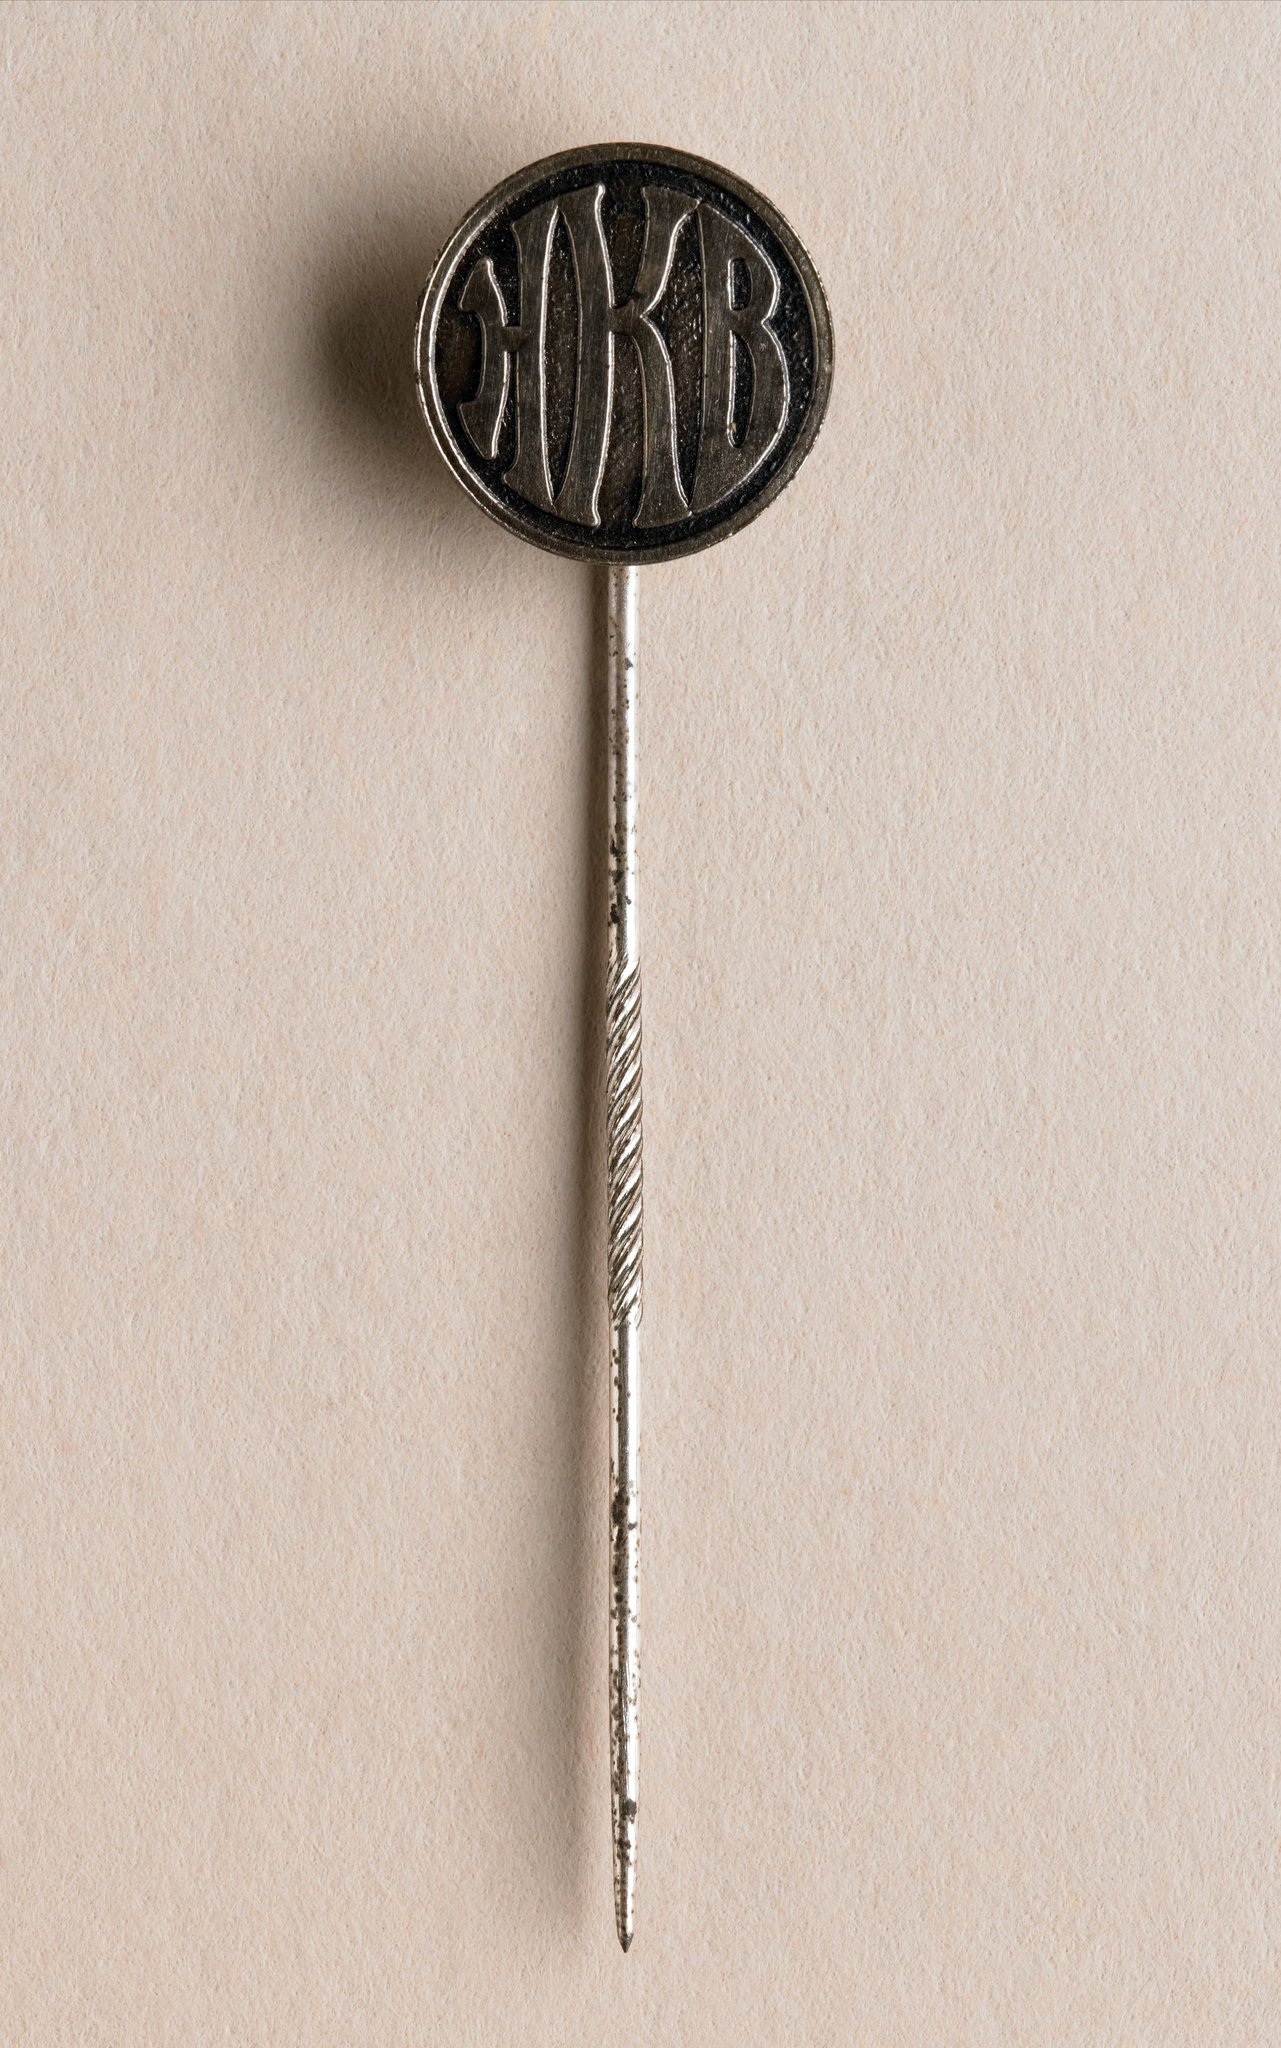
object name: pin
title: HKB - Korfbalbond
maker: Anonymous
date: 1925-1950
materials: metal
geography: netherlands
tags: amsterdam, willem drees, netherlands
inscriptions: inscription: ‘HKB’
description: Zilverkleurige speld van de korfbalbond HKB met lange gedraaide pen.